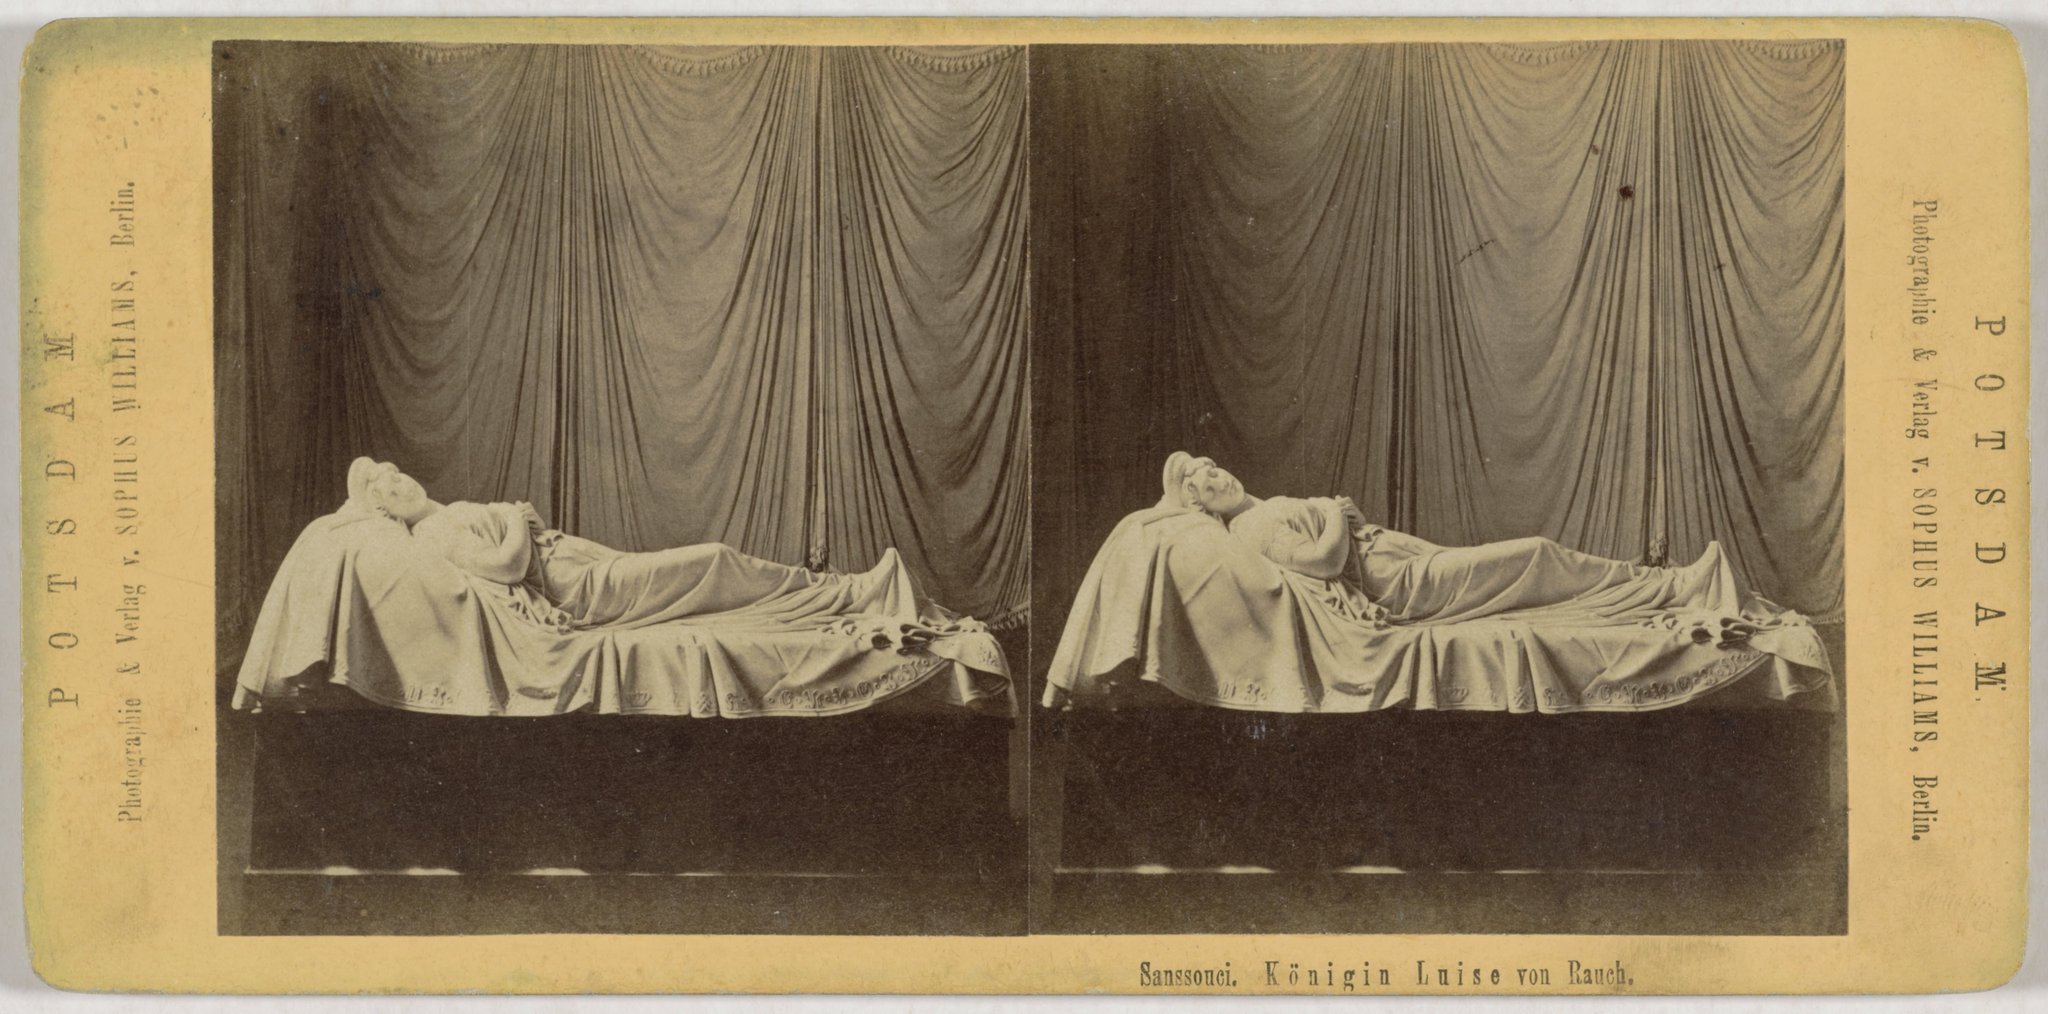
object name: stereograph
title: Potsdam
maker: sophus williams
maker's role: publisher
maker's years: 1835-1900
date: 1873-1890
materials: cardboard, paper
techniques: albumen print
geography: berlin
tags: sarcophagus